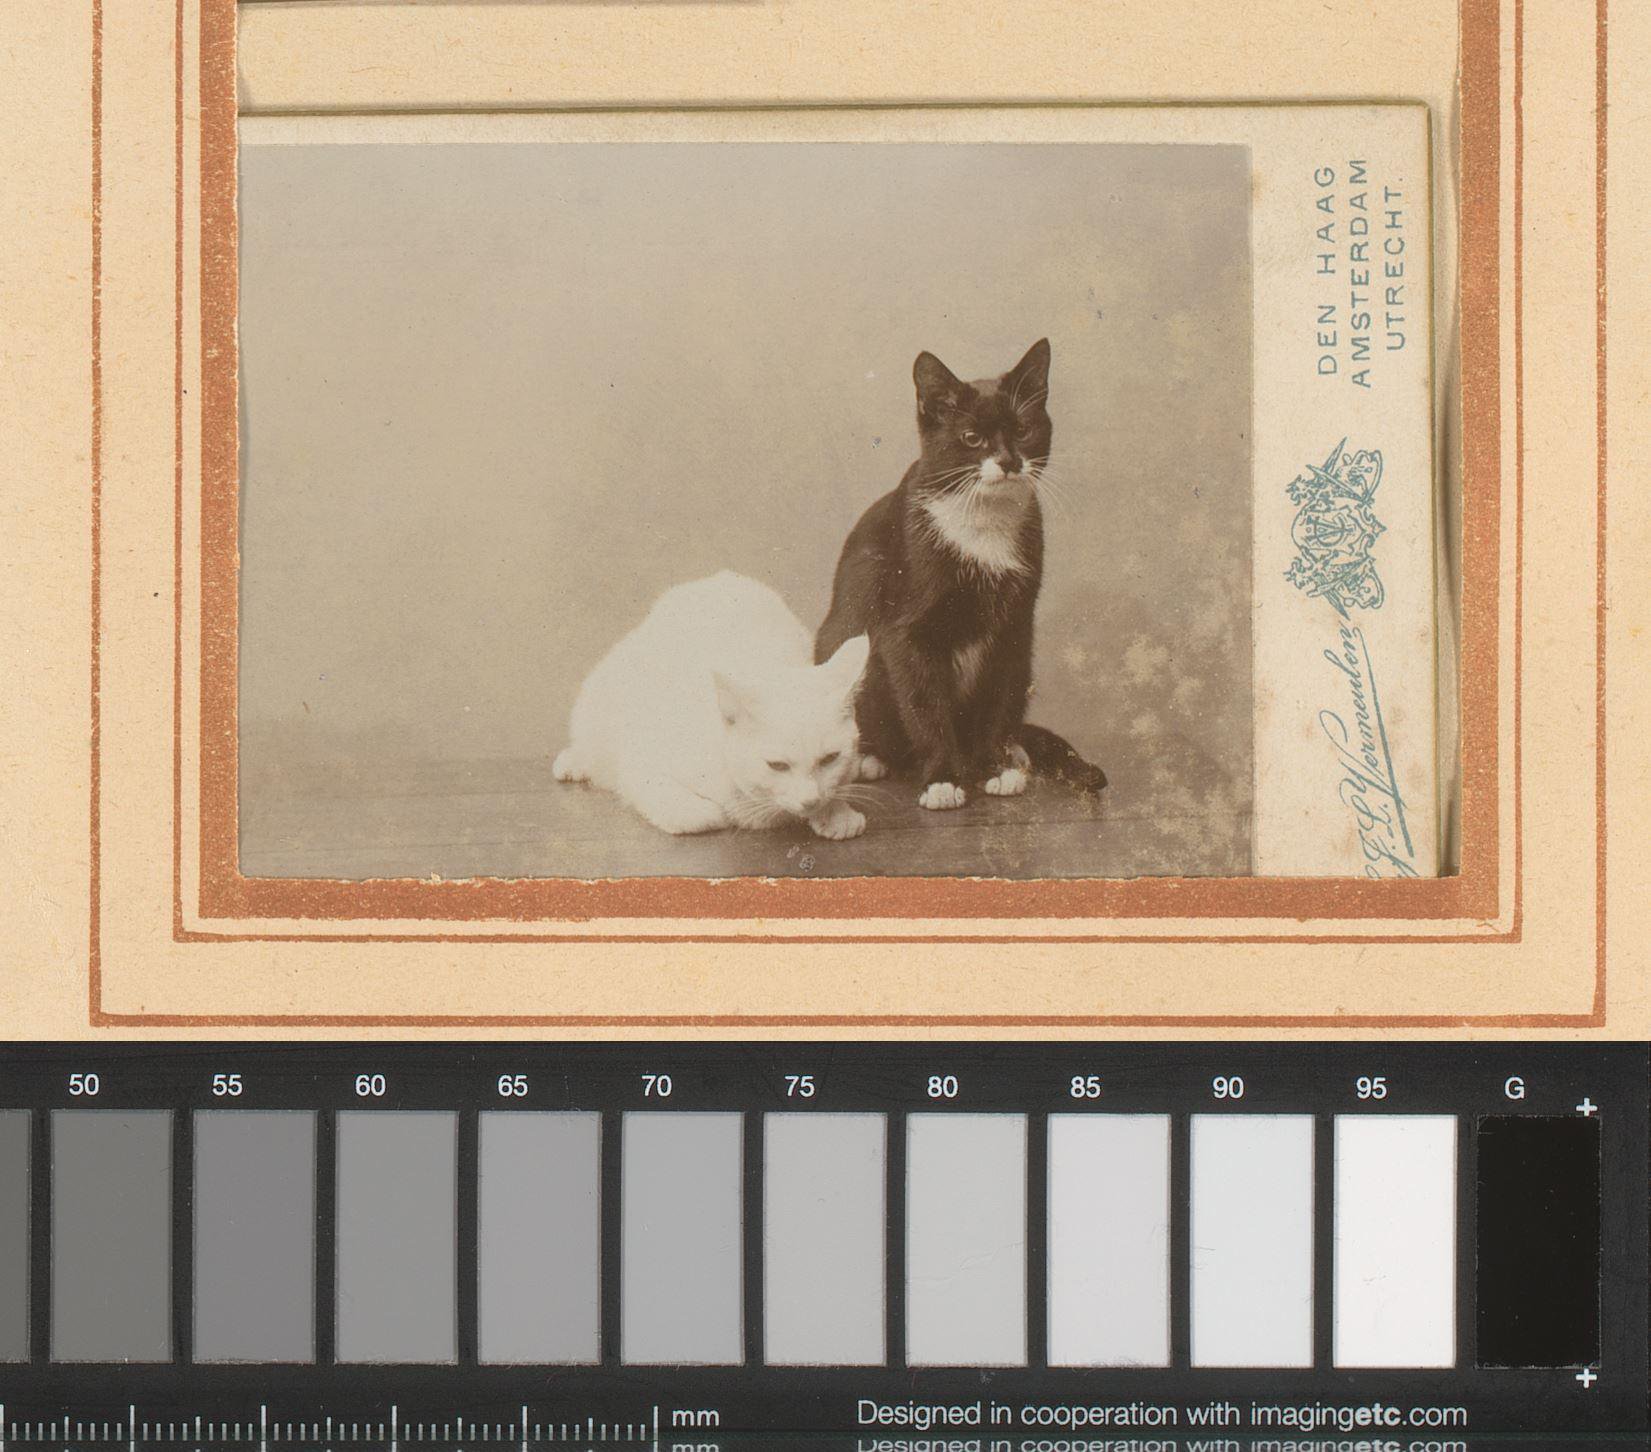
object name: photograph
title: Twee katten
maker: cornelis johannes lodewicus vermeulen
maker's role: fotograaf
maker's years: 1861-1936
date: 1890-1915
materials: cardboard, photographic support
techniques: collodion silver print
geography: netherlands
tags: cat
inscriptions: inscription: ‘C.J.L. Vermeulen/ Den Haag/ Amsterdam/ Utrecht’